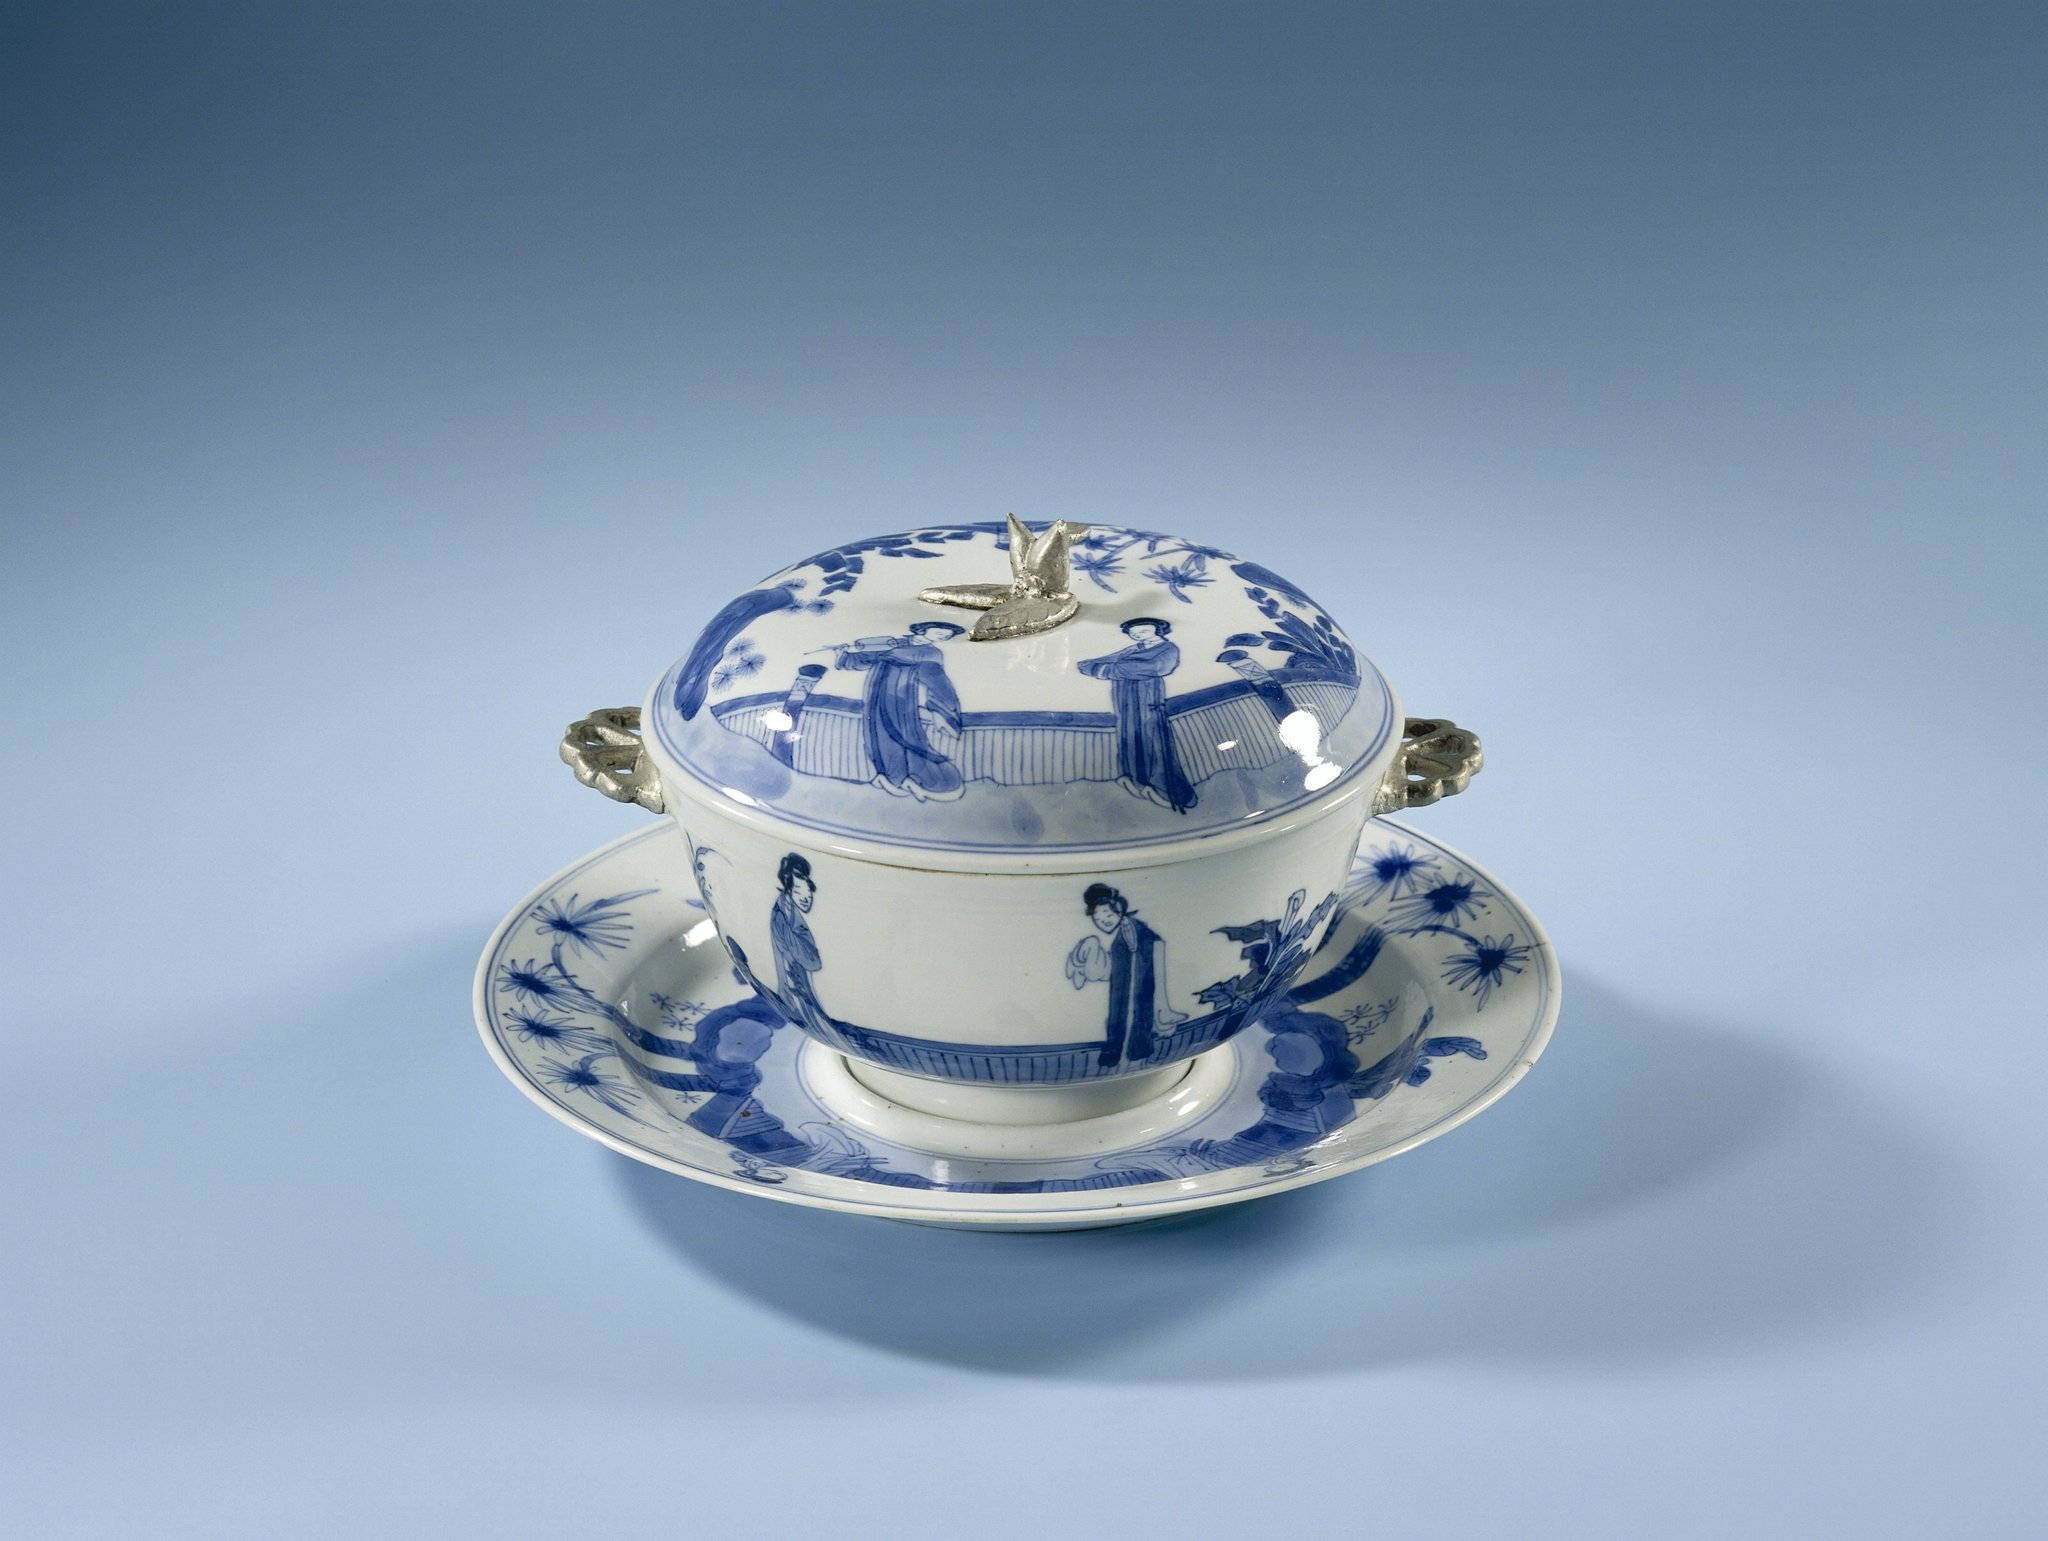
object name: bowl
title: Covered bowl with stand with women in a landscape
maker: Anonymous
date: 1700-1724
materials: biscuit porcelain, cobalt, glaze, material), paint, porcelain, silver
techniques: firing, turning, vitrification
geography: china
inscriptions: mark: ‘大 清 康 熙 年 製’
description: Bowl with lid and saucer